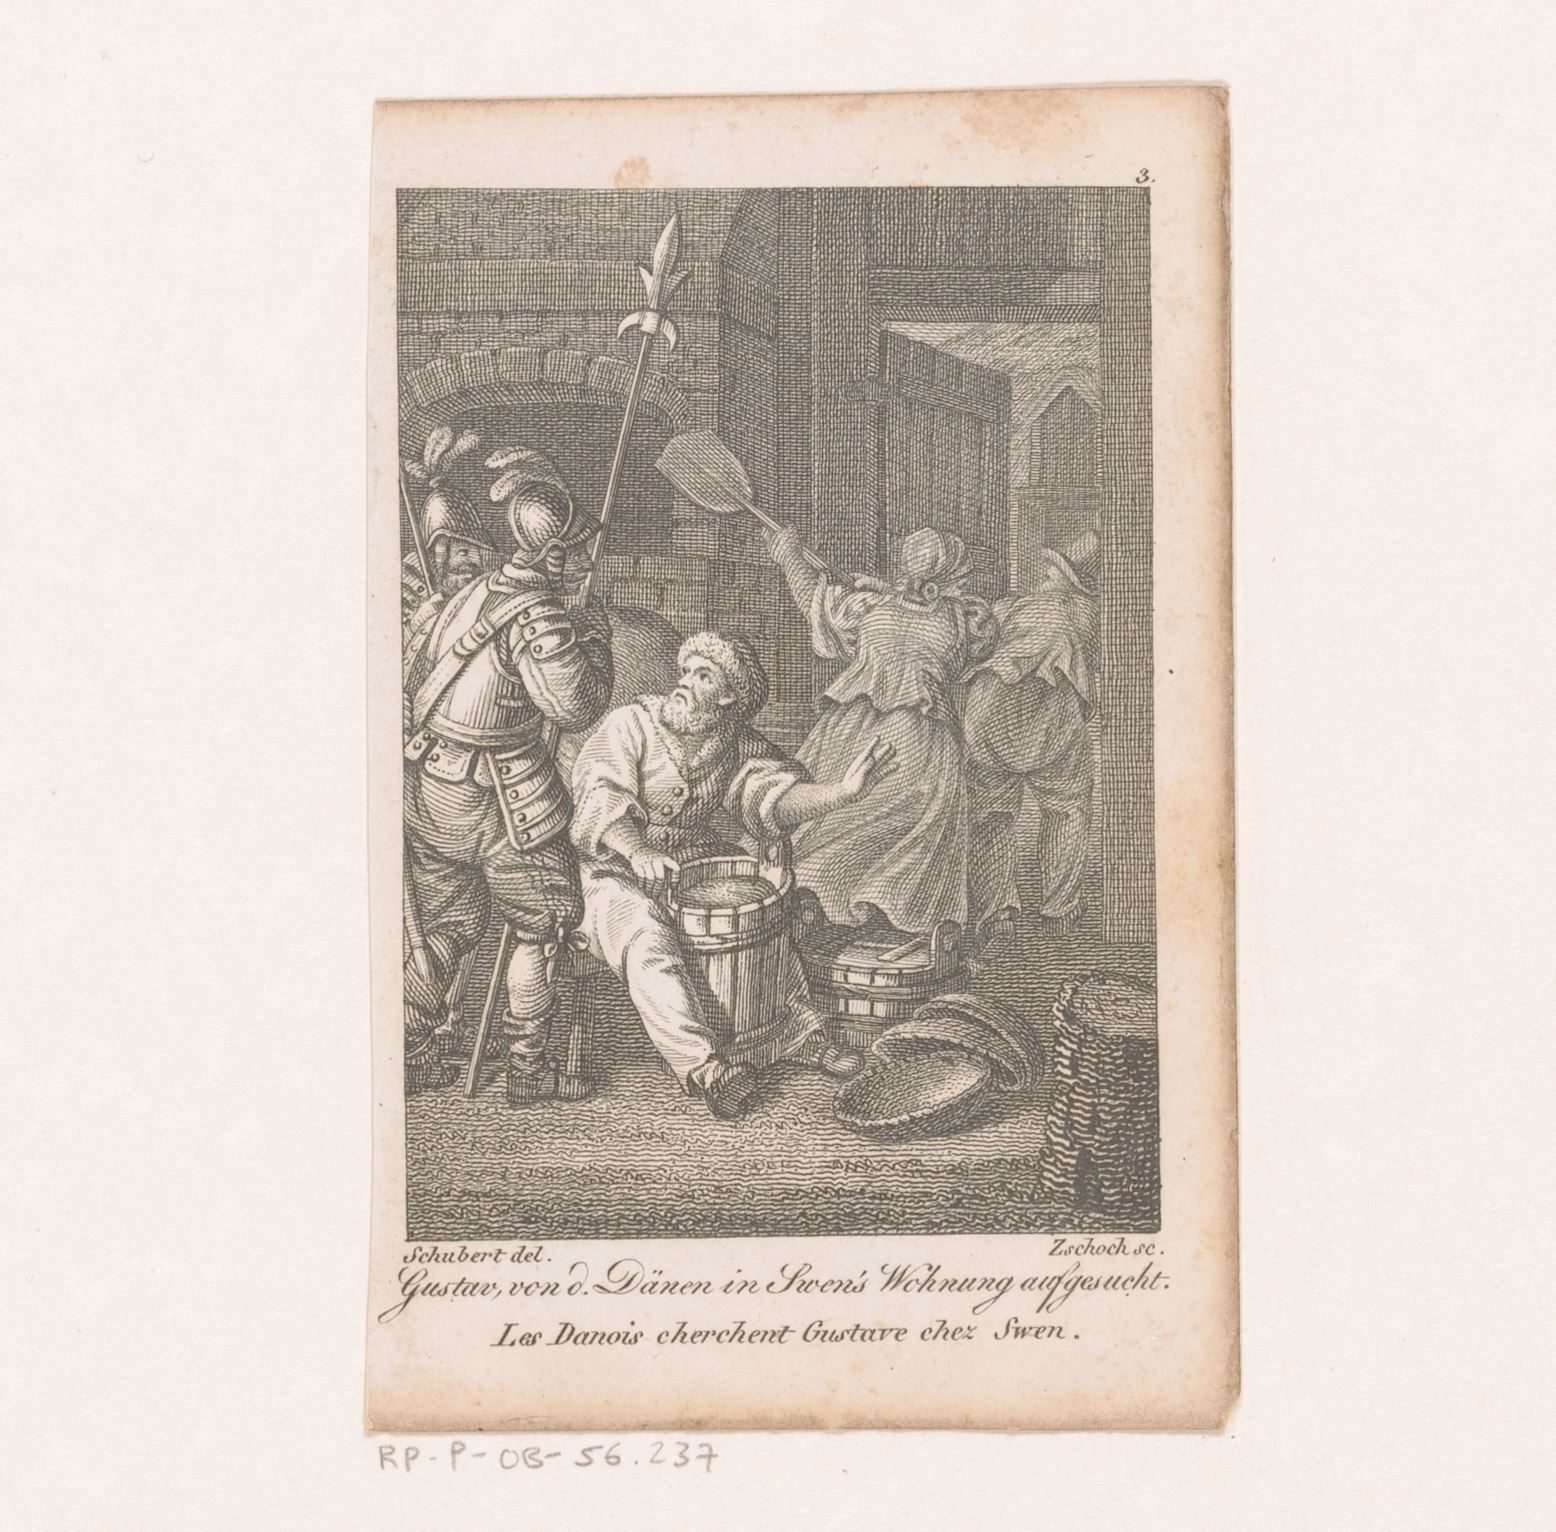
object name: print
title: Gustav, von d. Dänen in Swen's Wohnung aufgesucht / Les Danois cherchent Gustave chez Swen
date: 1785-1833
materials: paper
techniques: etching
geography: germany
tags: the soldier; the soldier's life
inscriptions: collector's mark: Lugt 2228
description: Deze prent maakt deel uit van een serie van onbekende omvang met scènes uit de geschiedenis van Zweden.